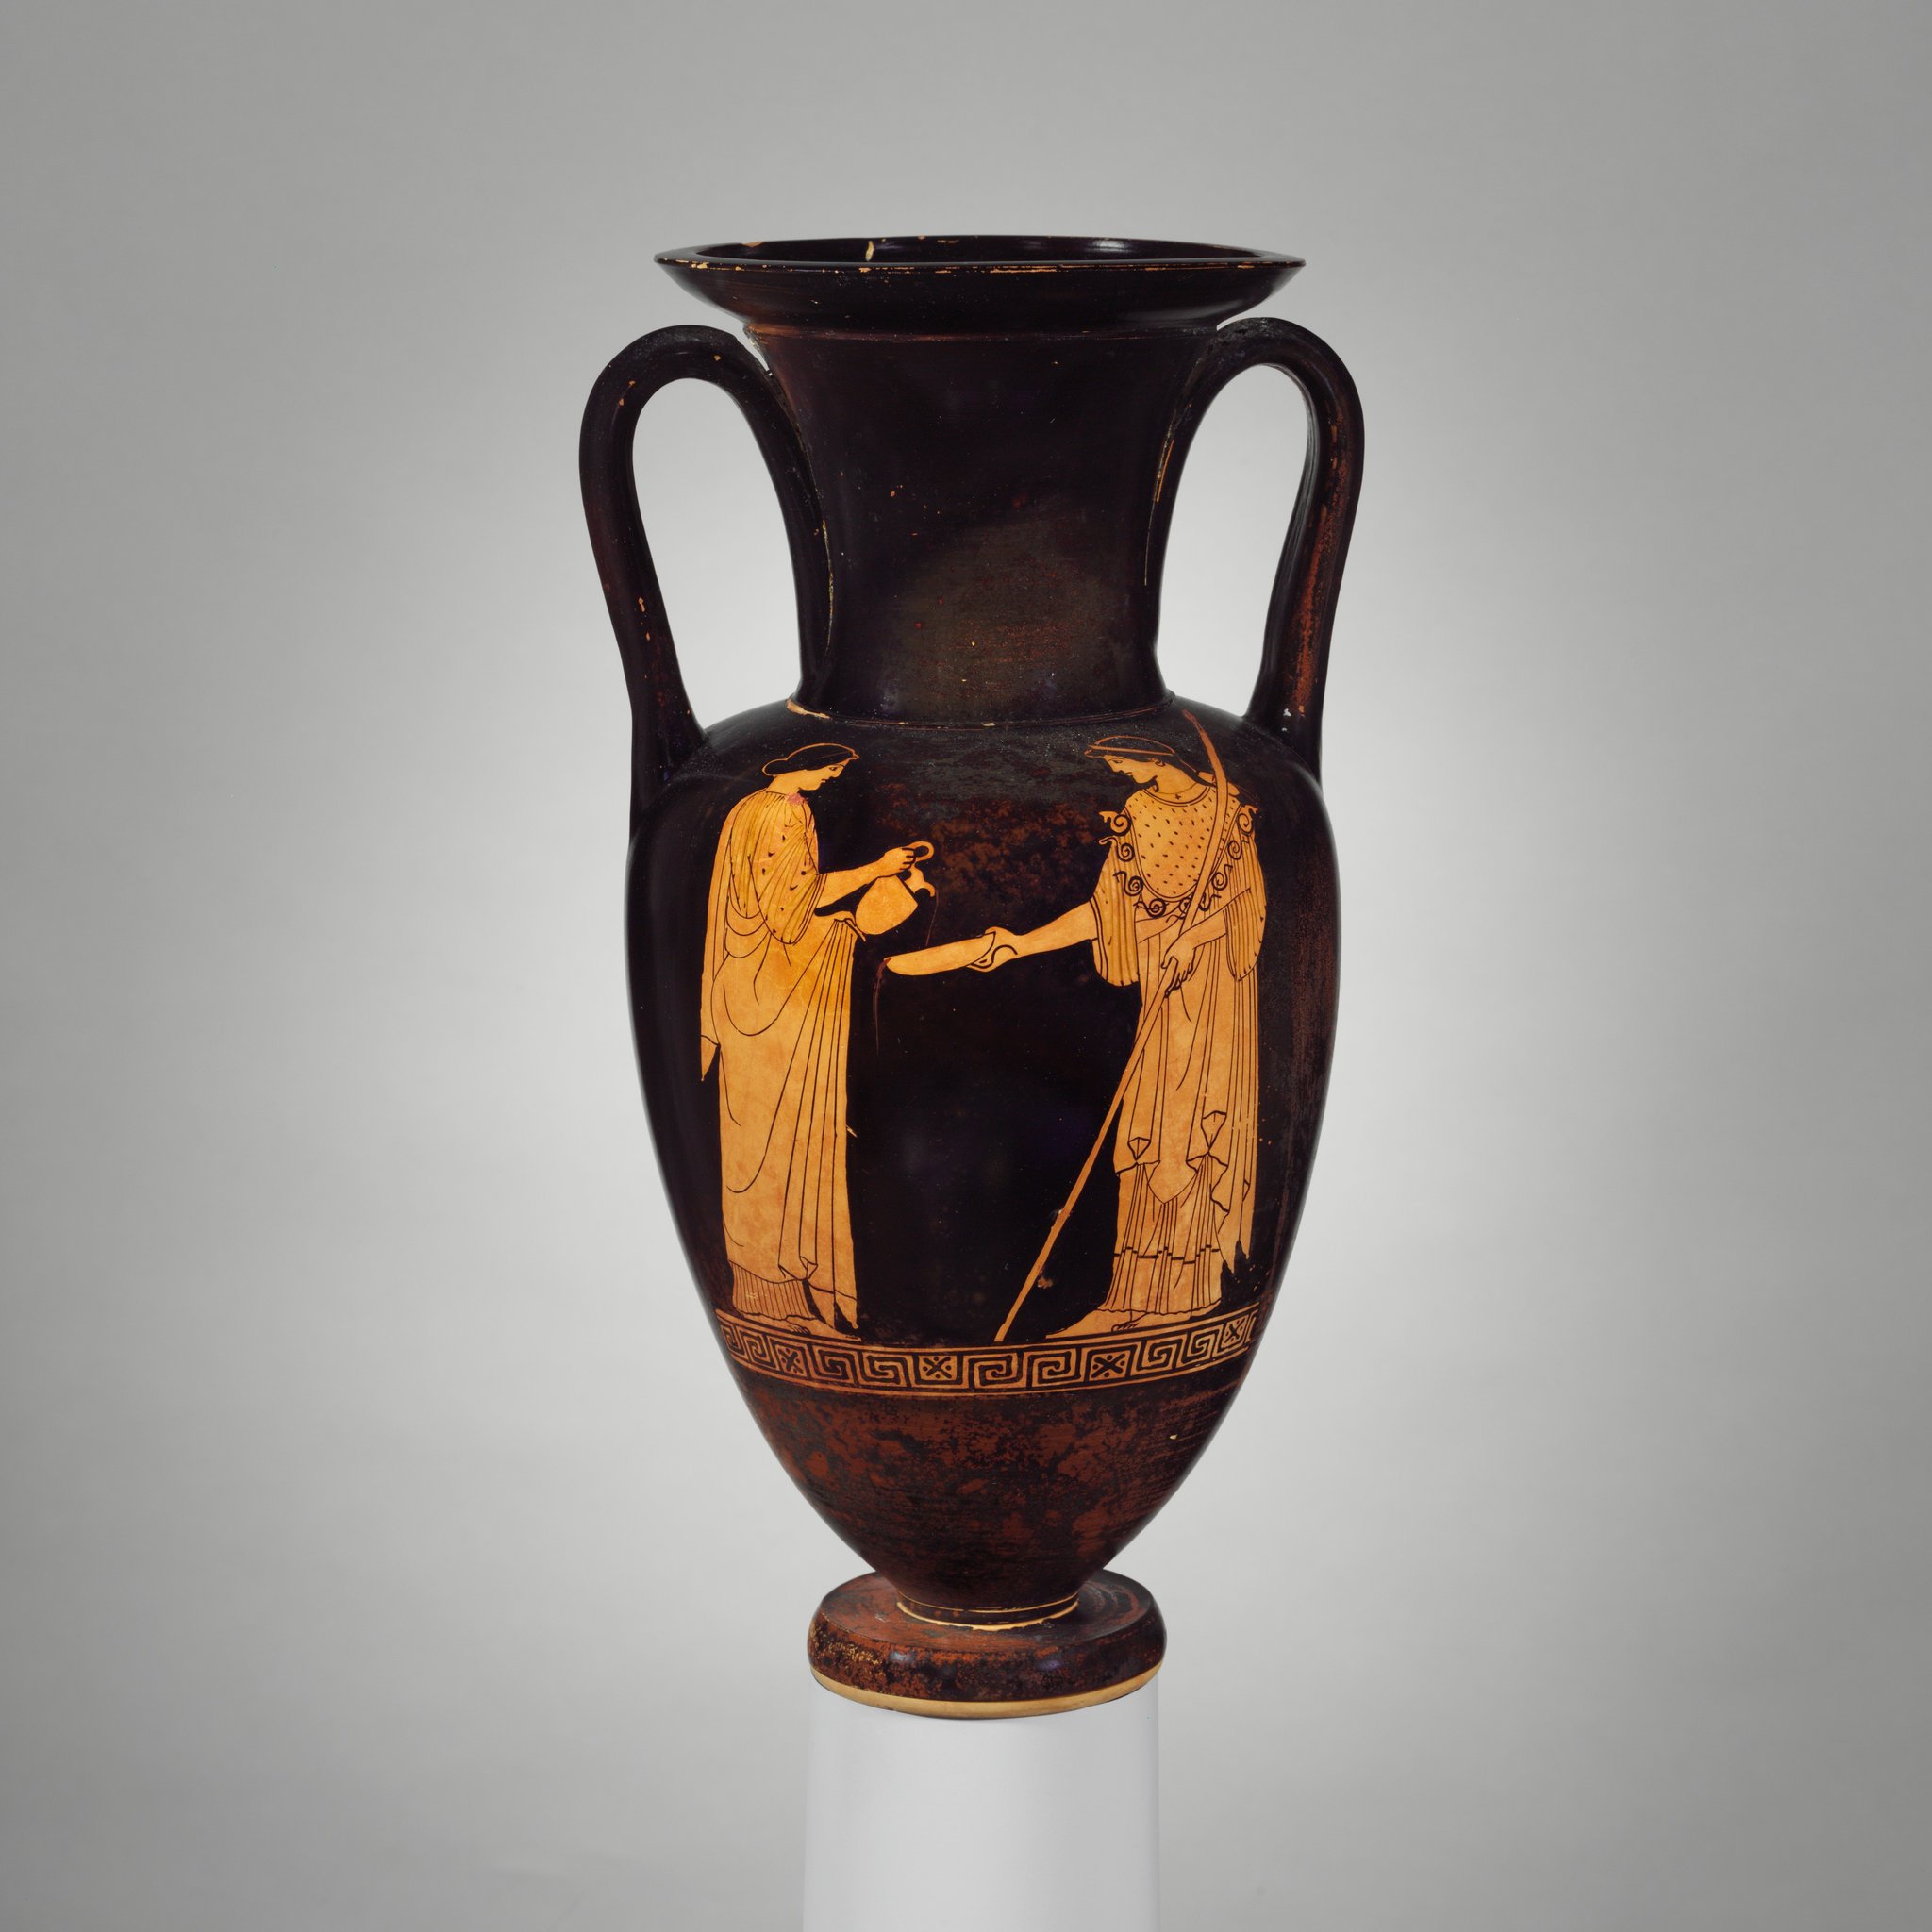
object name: nolan neck amphora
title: Terracotta Nolan neck-amphora (jar)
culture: greek, attic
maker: achilles painter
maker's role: artist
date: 460-450 BCE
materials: terracotta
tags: men,women,athena